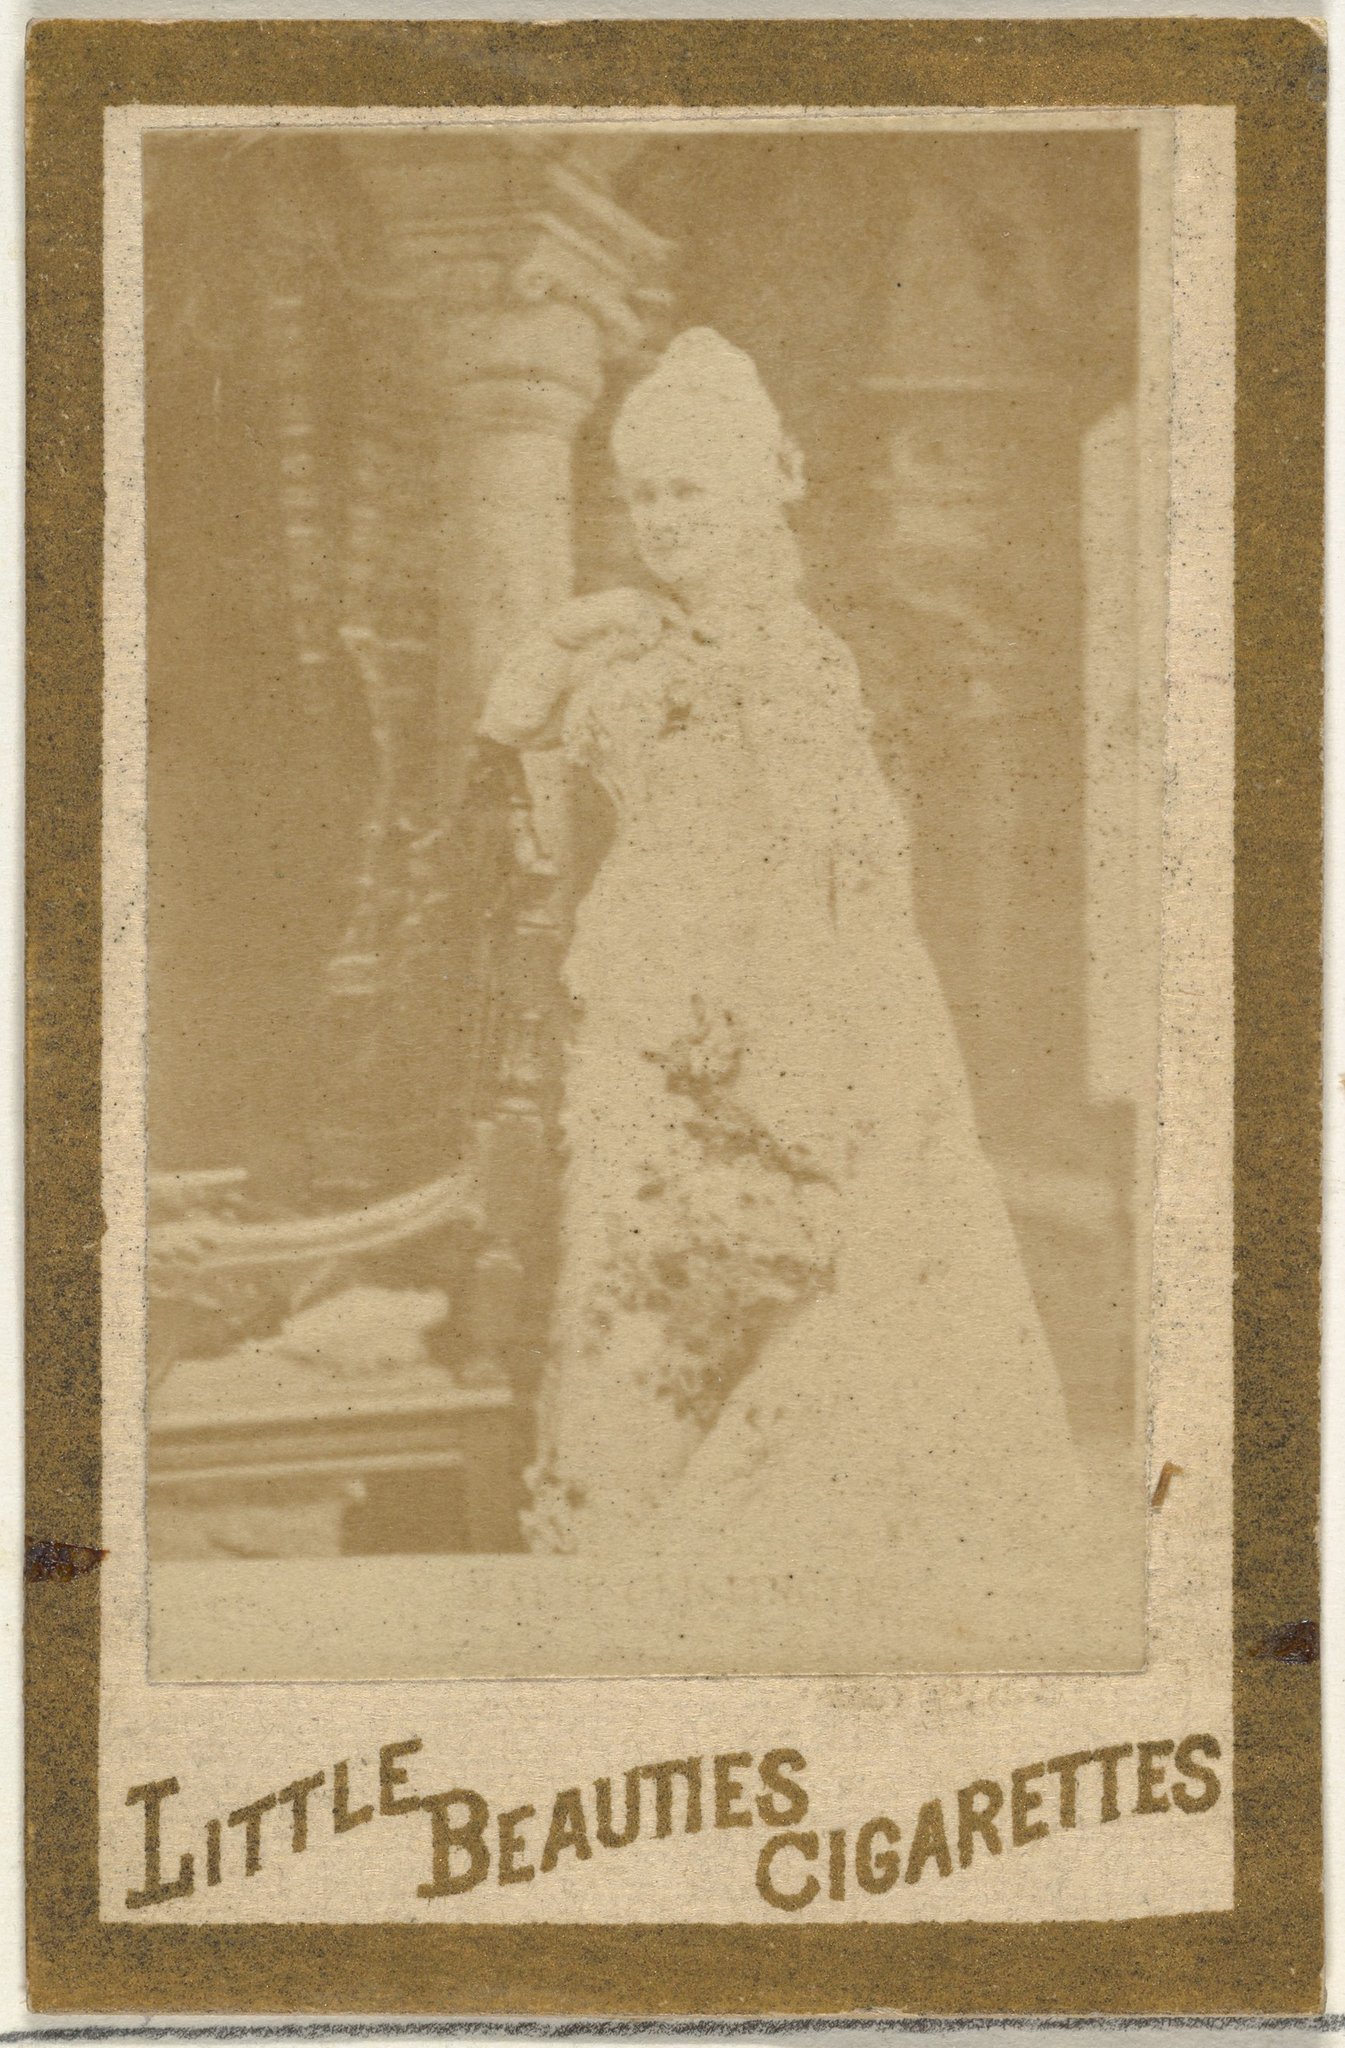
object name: photograph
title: From the Actresses and Celebrities series (N60, Type 1) promoting Little Beauties Cigarettes for Allen & Ginter brand tobacco products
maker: allen & ginter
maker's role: publisher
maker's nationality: american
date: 1887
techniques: albumen silver print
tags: portraits,women,actresses